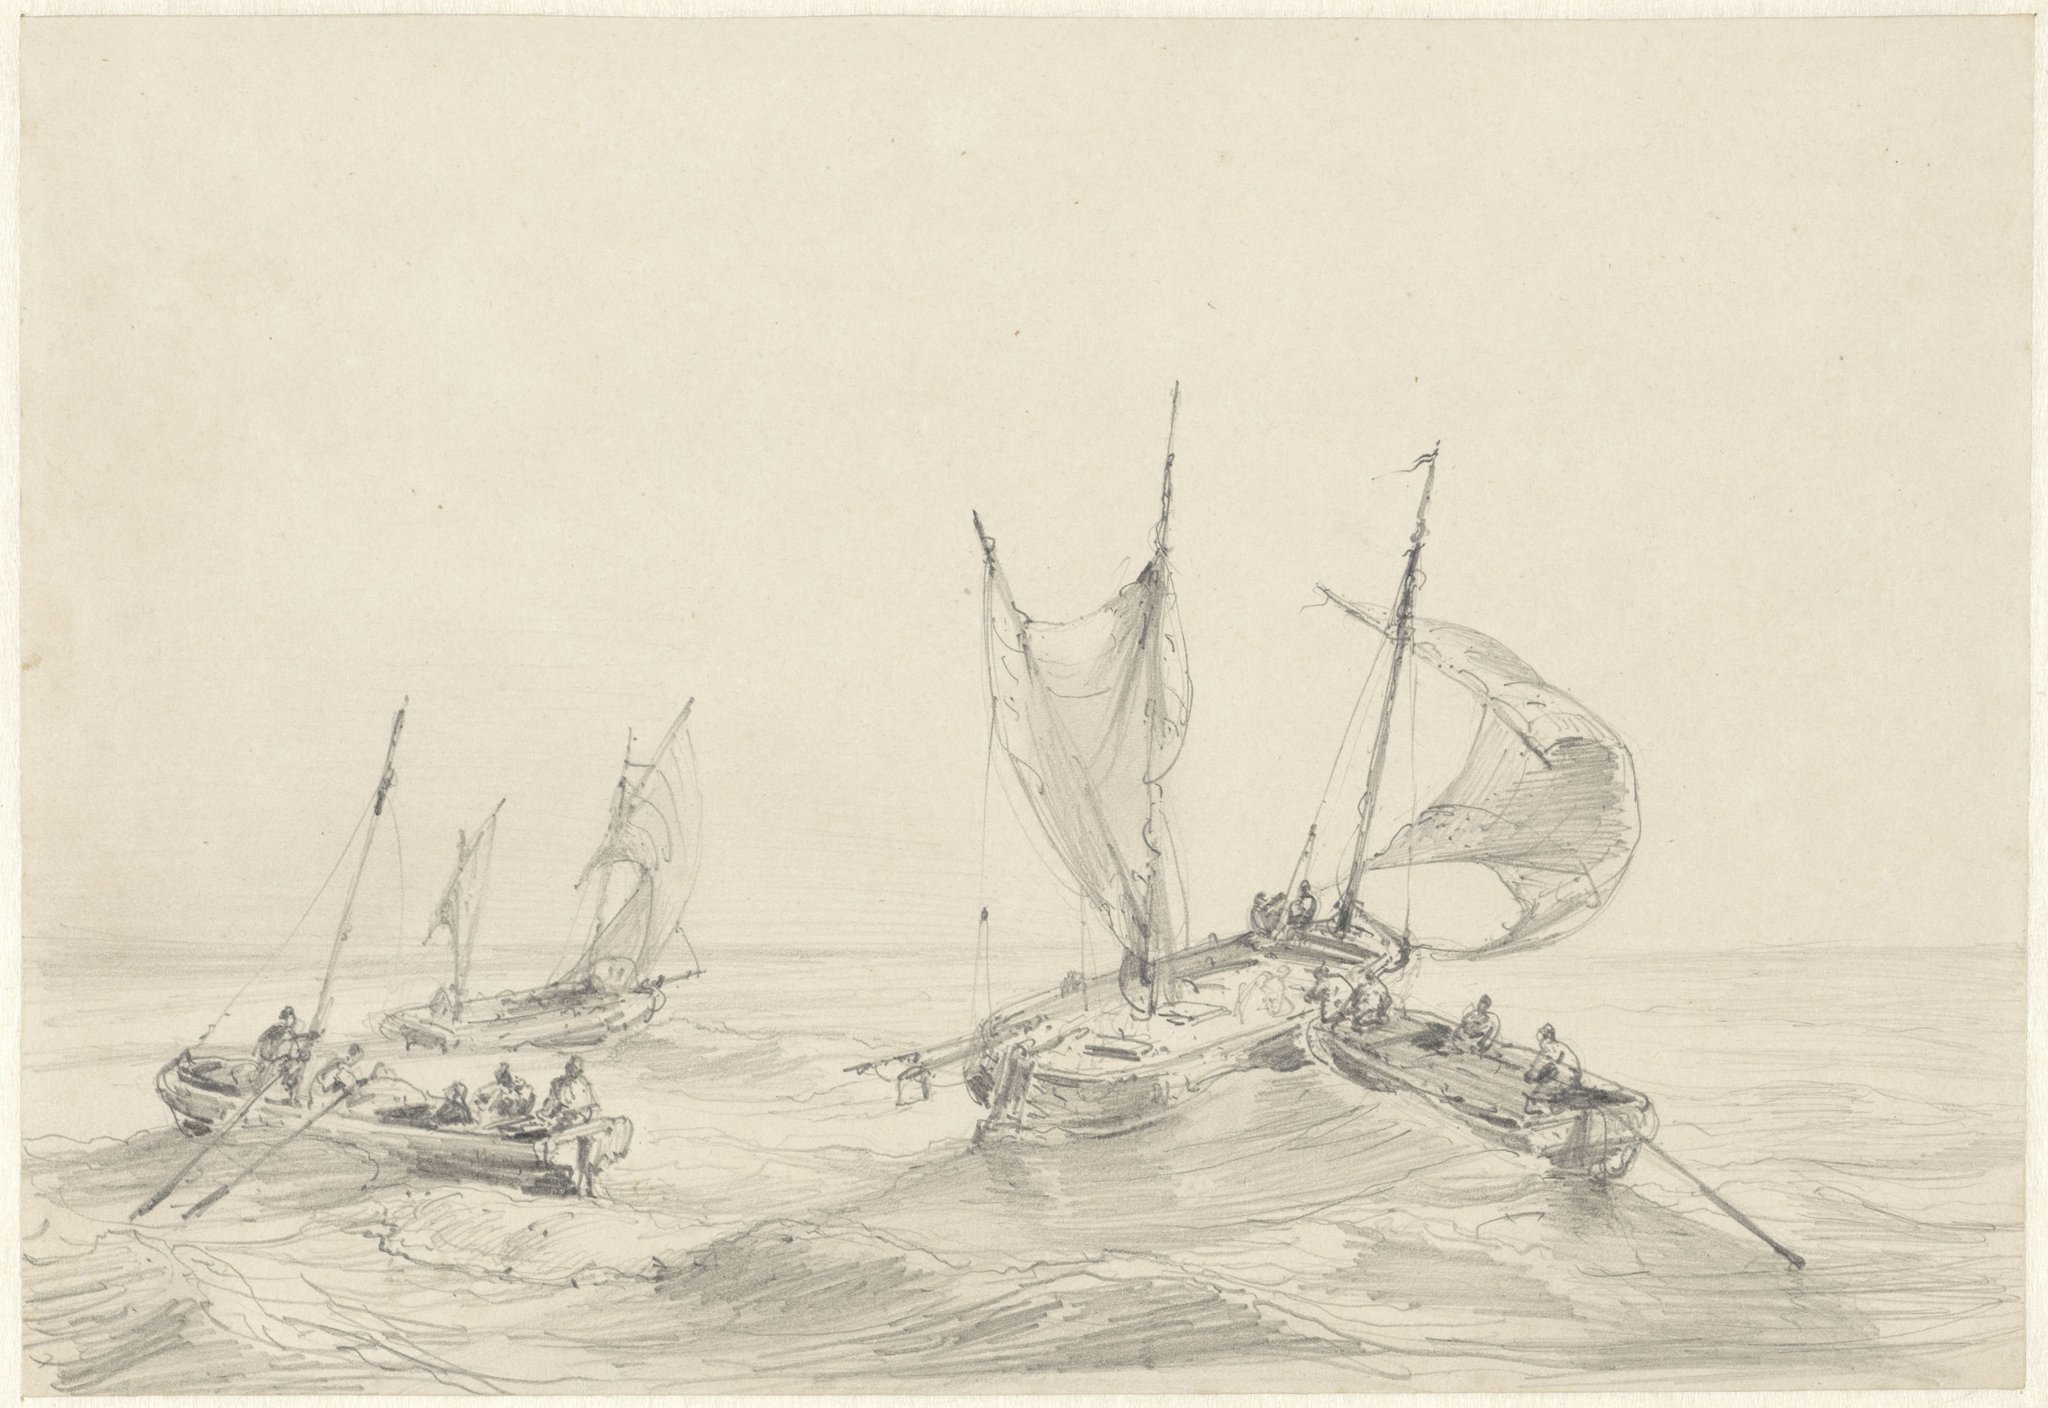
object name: drawing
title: Zee met vissersschepen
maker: louis meijer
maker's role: draughtsman, painter, print maker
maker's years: 1809-1866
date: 1819-1866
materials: paper, pencil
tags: sailing-ship, sailing-boat, sea (seascape)